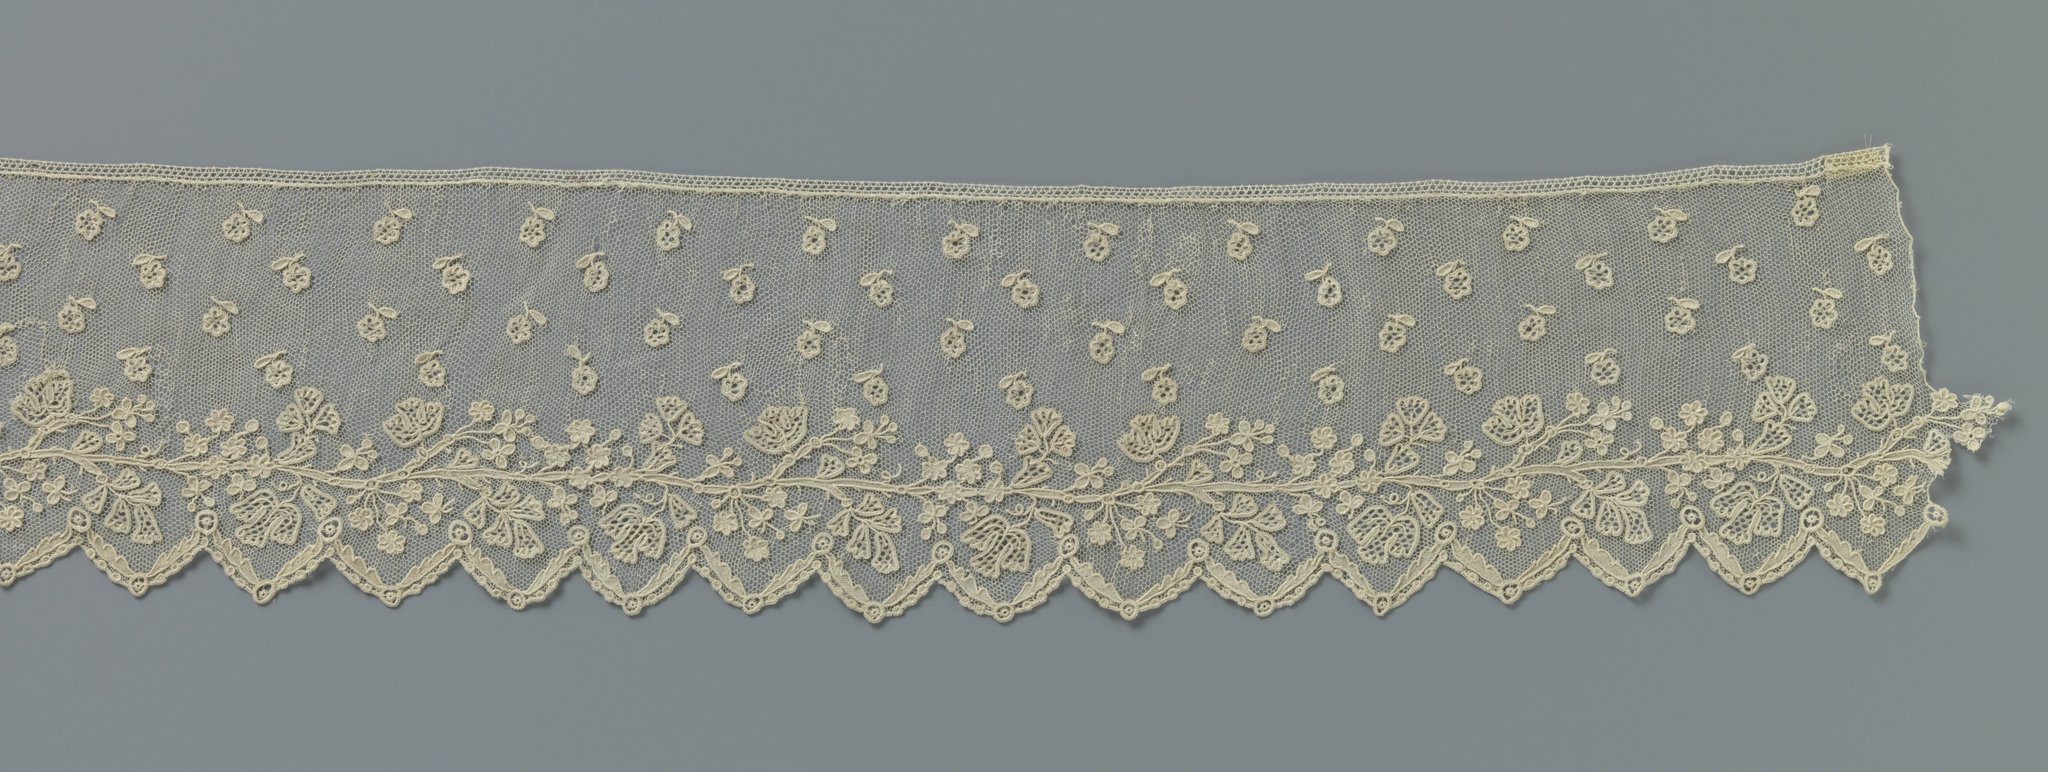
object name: strip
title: Strook naaldkant met zigzagschulpen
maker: Anonymous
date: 1810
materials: linen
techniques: lace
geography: france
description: Aan een strakke, liggende tak groeien naar rechts gerichte zijtakjes, waaraan vergeetmijnietjes en drie typen van kelkbloempjes, De scherpe zigzagschulpen vertonen een dubbele contour, bestaande uit een blad- en een parelrandje, terwijl op elke punt een 'lovertje' is aangebracht. In het veld staat een strooipatroon van neerhangende madeliefjes. Alençon-kant.